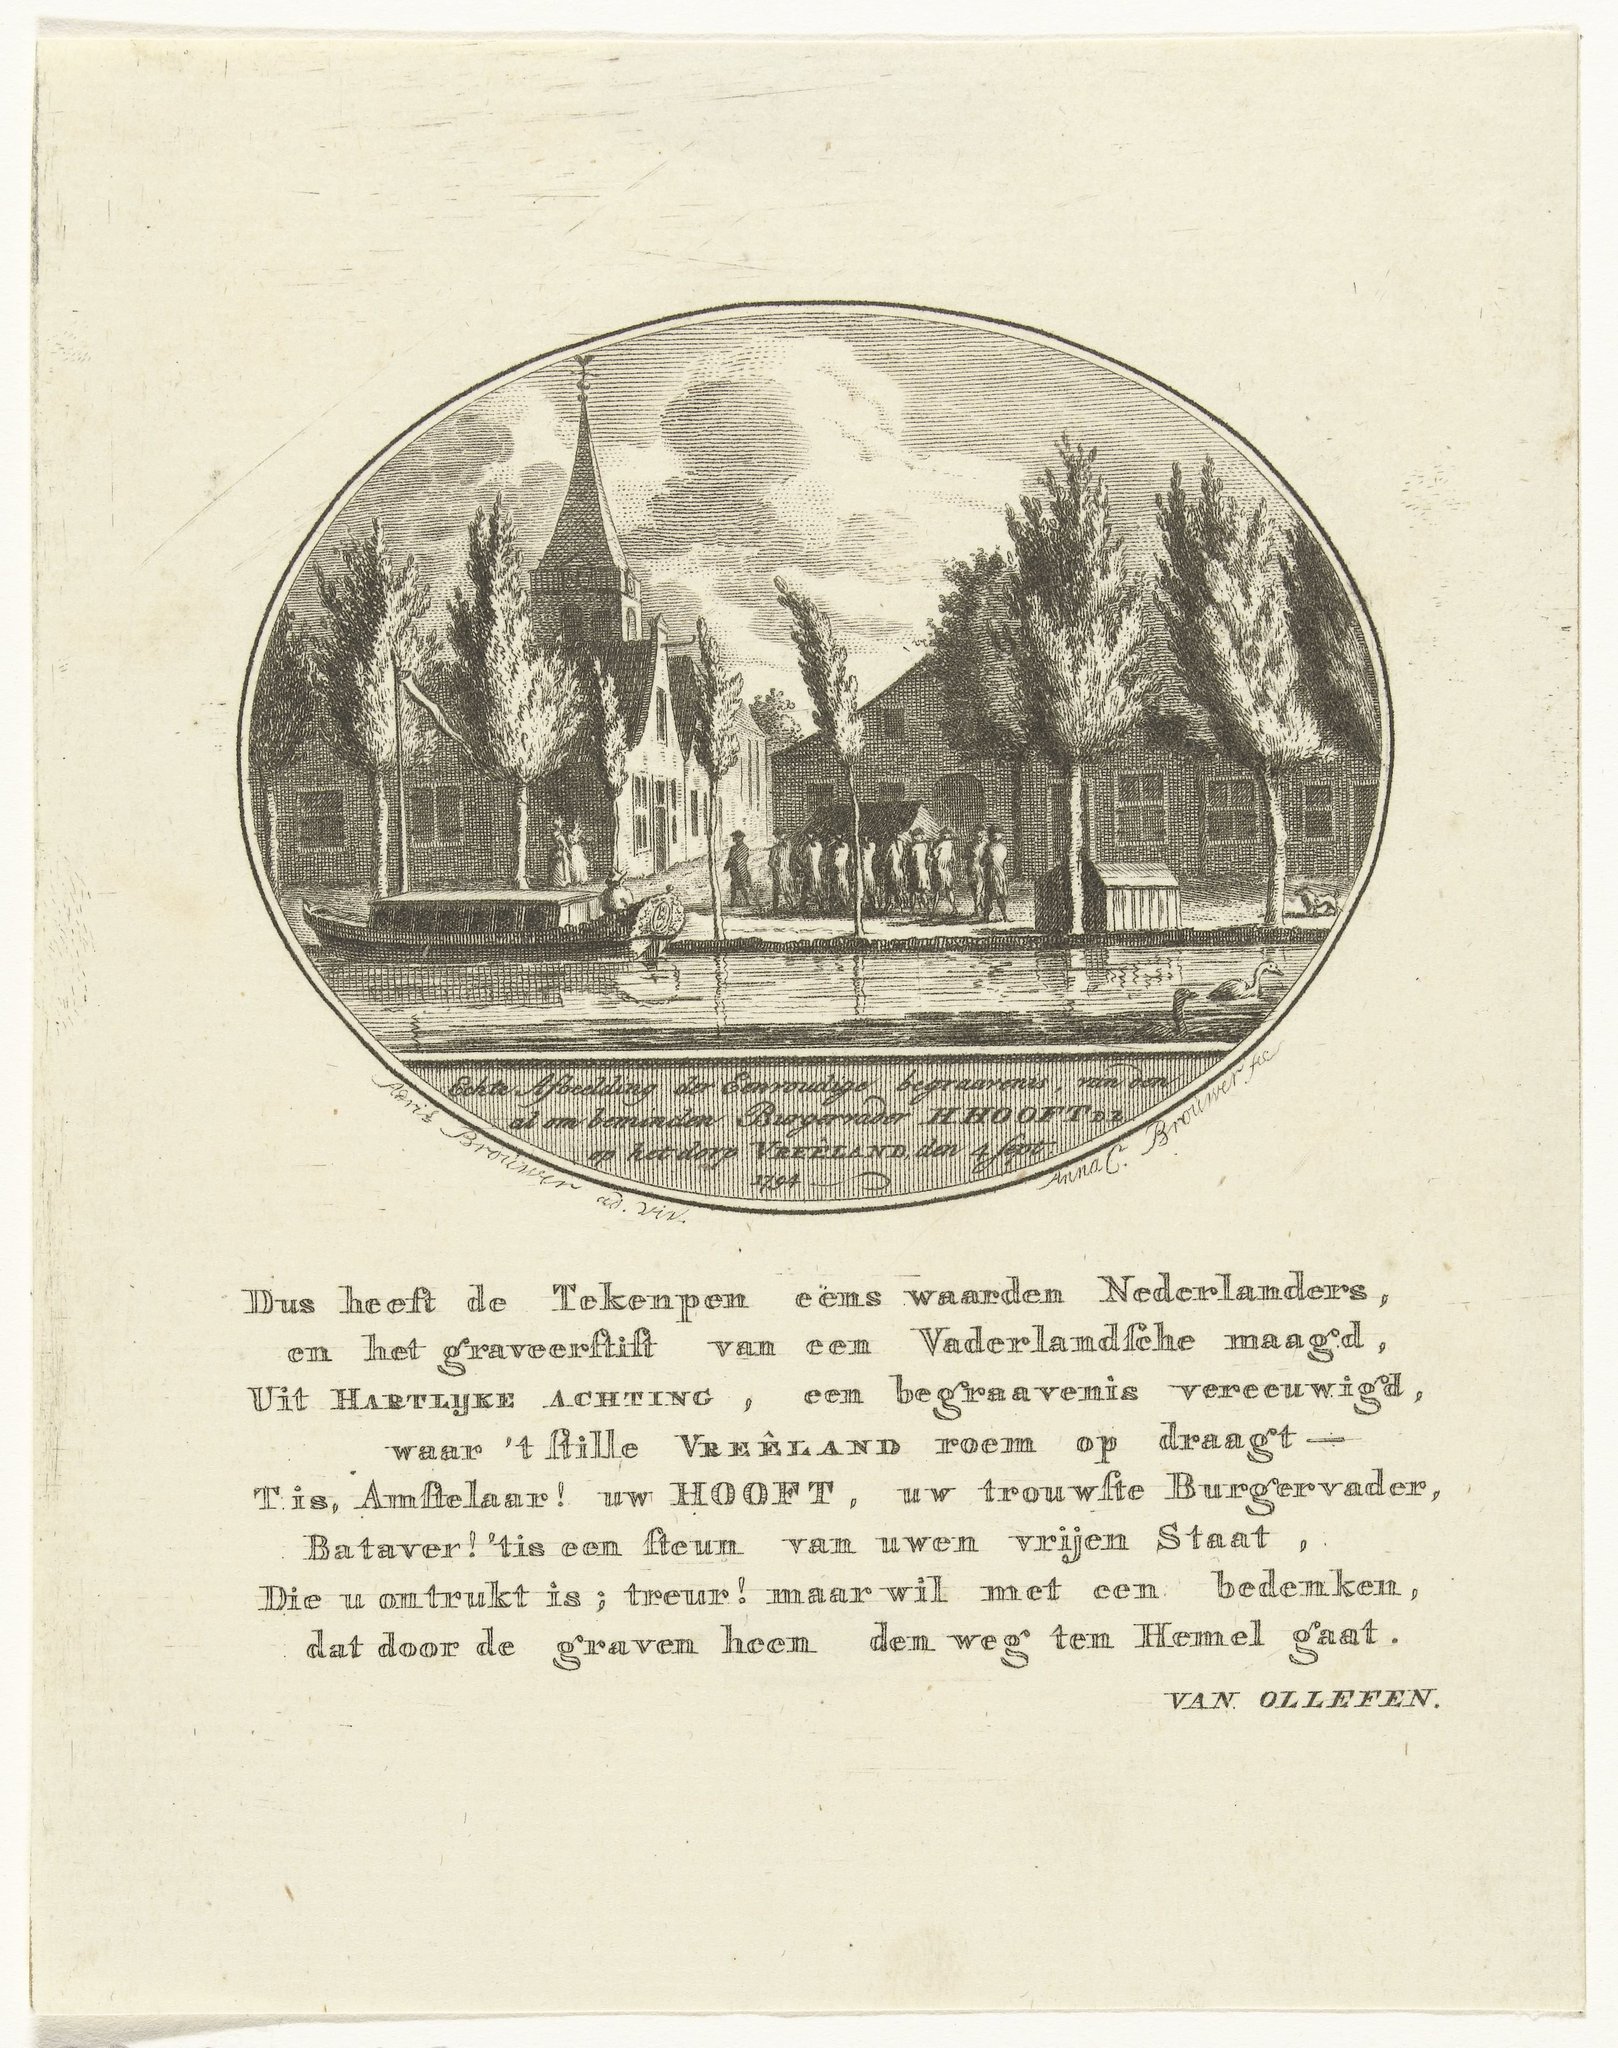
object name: book illustration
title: Begrafenisstoet van H. Hooft Dz. te Vreeland, 1794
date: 1794-1801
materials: paper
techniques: etching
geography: amsterdam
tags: amsterdam, mayor, hendrik danielsz. hooft, city-view in general; 'veduta', funerary ceremonial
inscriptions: collector's mark: Lugt 2228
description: afkomstig uit: L. van Ollefen, De Nederlandsche stad- en dorpbeschrijver. Amsterdam: H.A. Banse, 1793-1801.